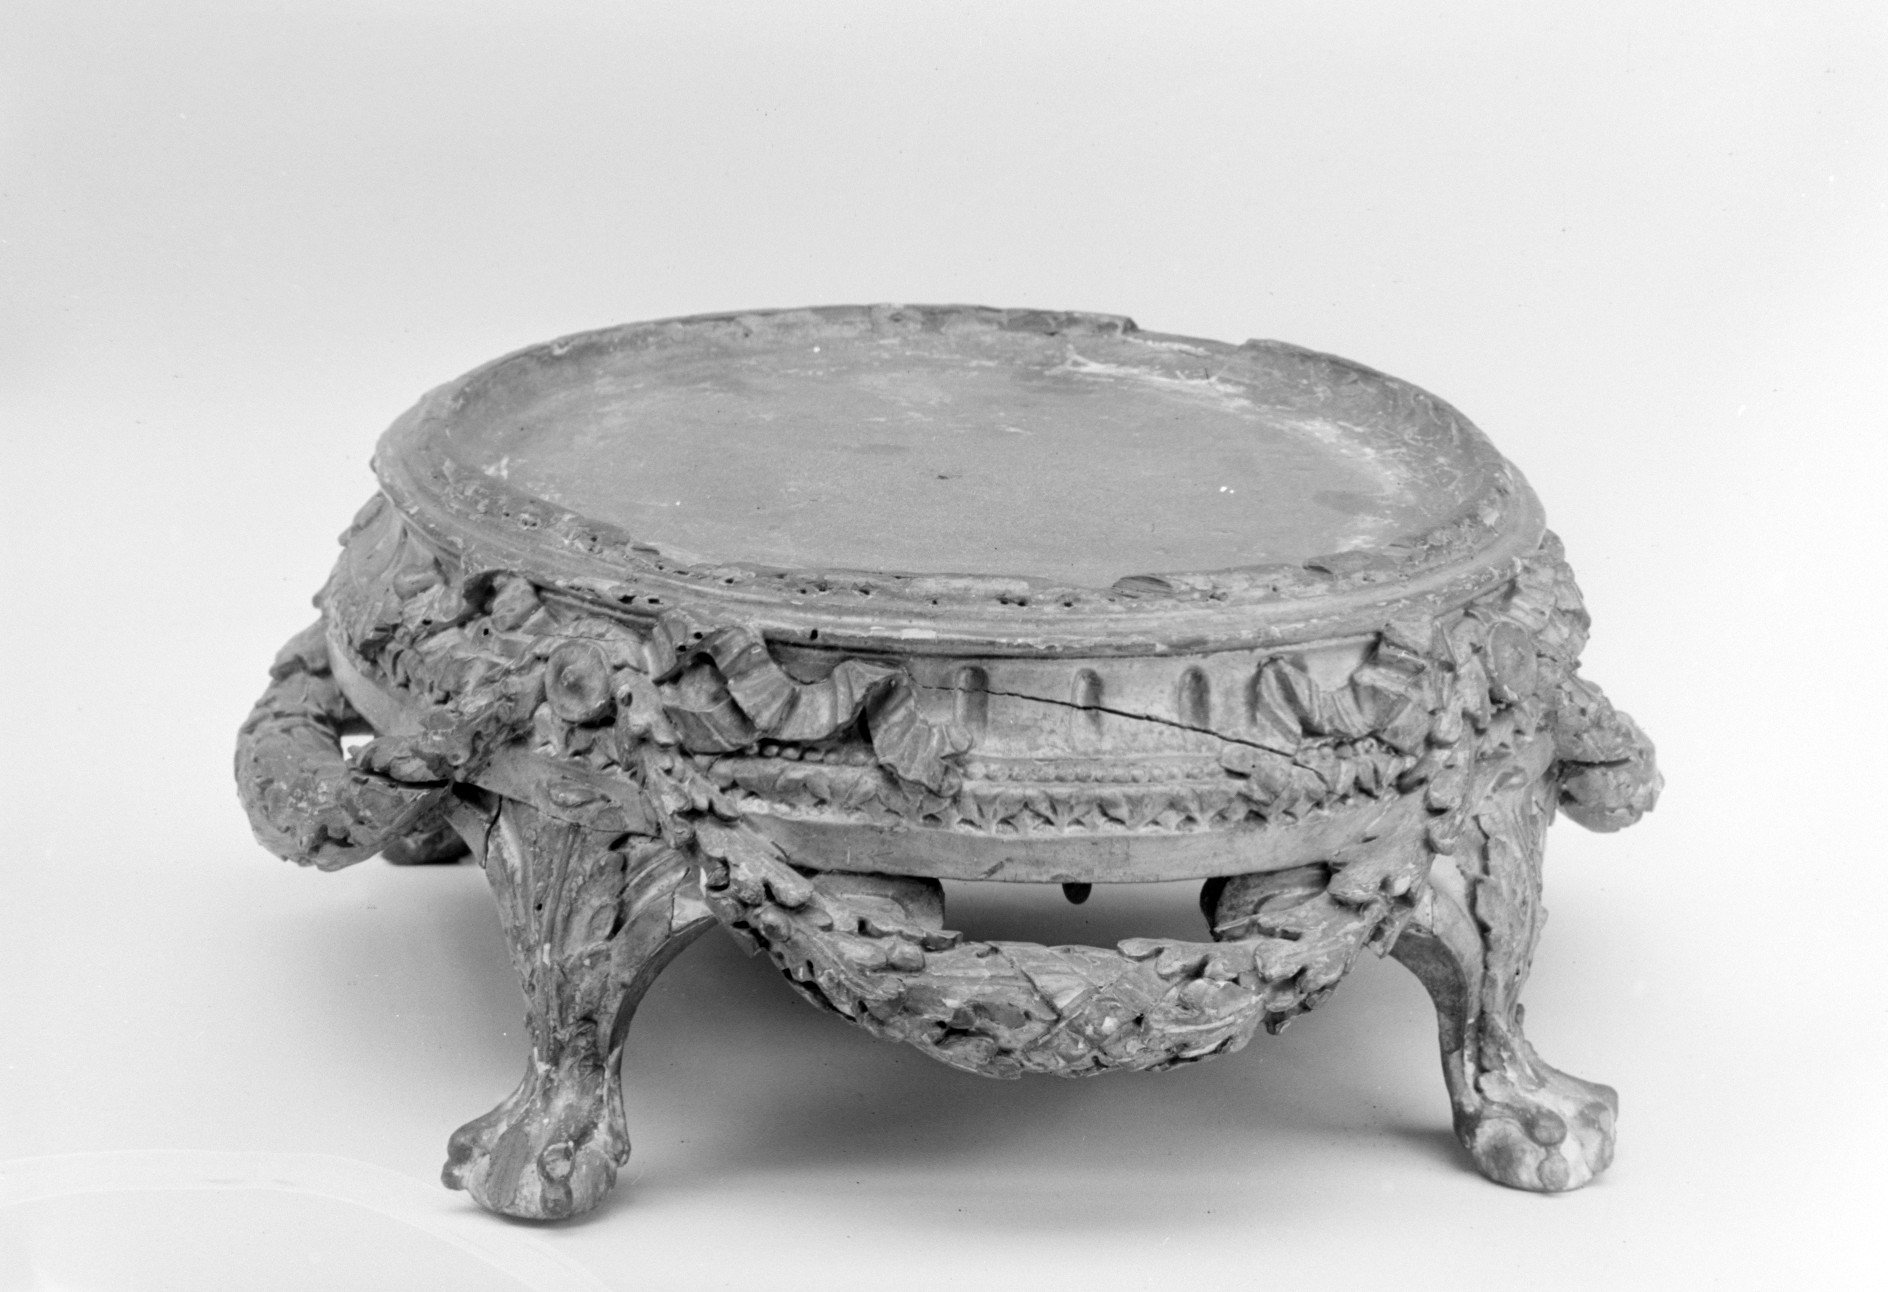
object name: vase stand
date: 1701-1800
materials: wood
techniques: carving, gilding